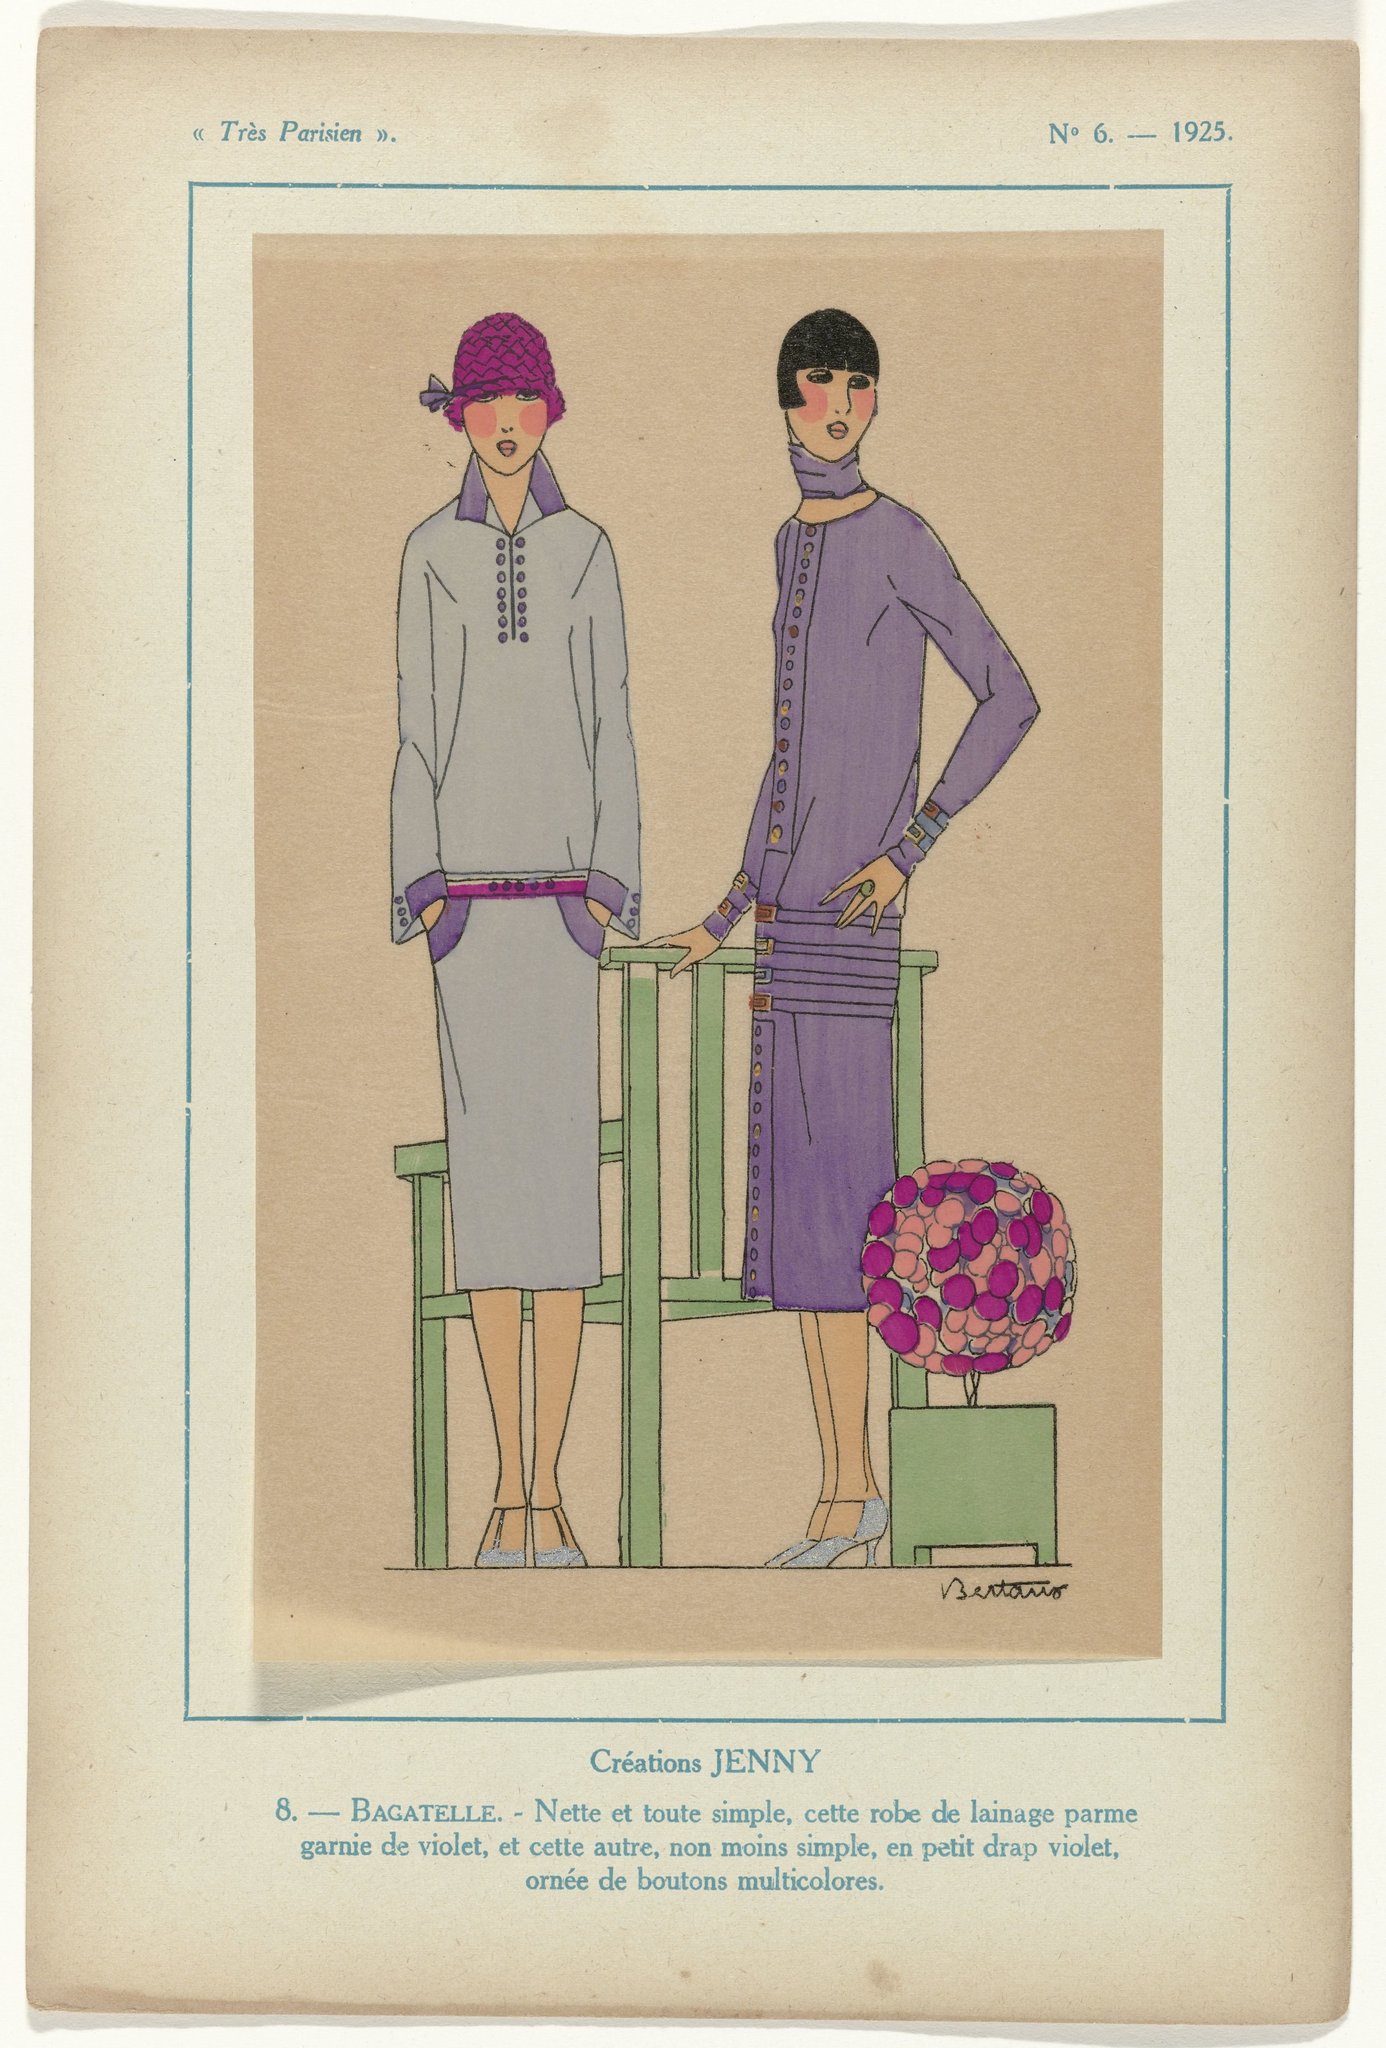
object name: fashion print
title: Très Parisien, 1925, No. 6, Pl. 8: Créations JENNY. -BAGATELLE.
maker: g-p. joumard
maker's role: publisher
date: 1925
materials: paper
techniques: hand coloring, letterpress printing, lithography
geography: paris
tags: dress, gown: day dress (+ women's clothes), fashion plates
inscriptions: caption: ‘8. - BAGATELLE. - Nette et toute simple, cette robe de lainage parme garnie de violet, et cette autre, non moins simple, en petit drap violet, ornée de boutons multicolores.’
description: Creaties Jenny: Twee eenvoudige japonnen in licht- en donkerpaars. Prent uit het modetijdschrift Très Parisien...La Mode, Le Chic, L'Élégance (1920-1936)